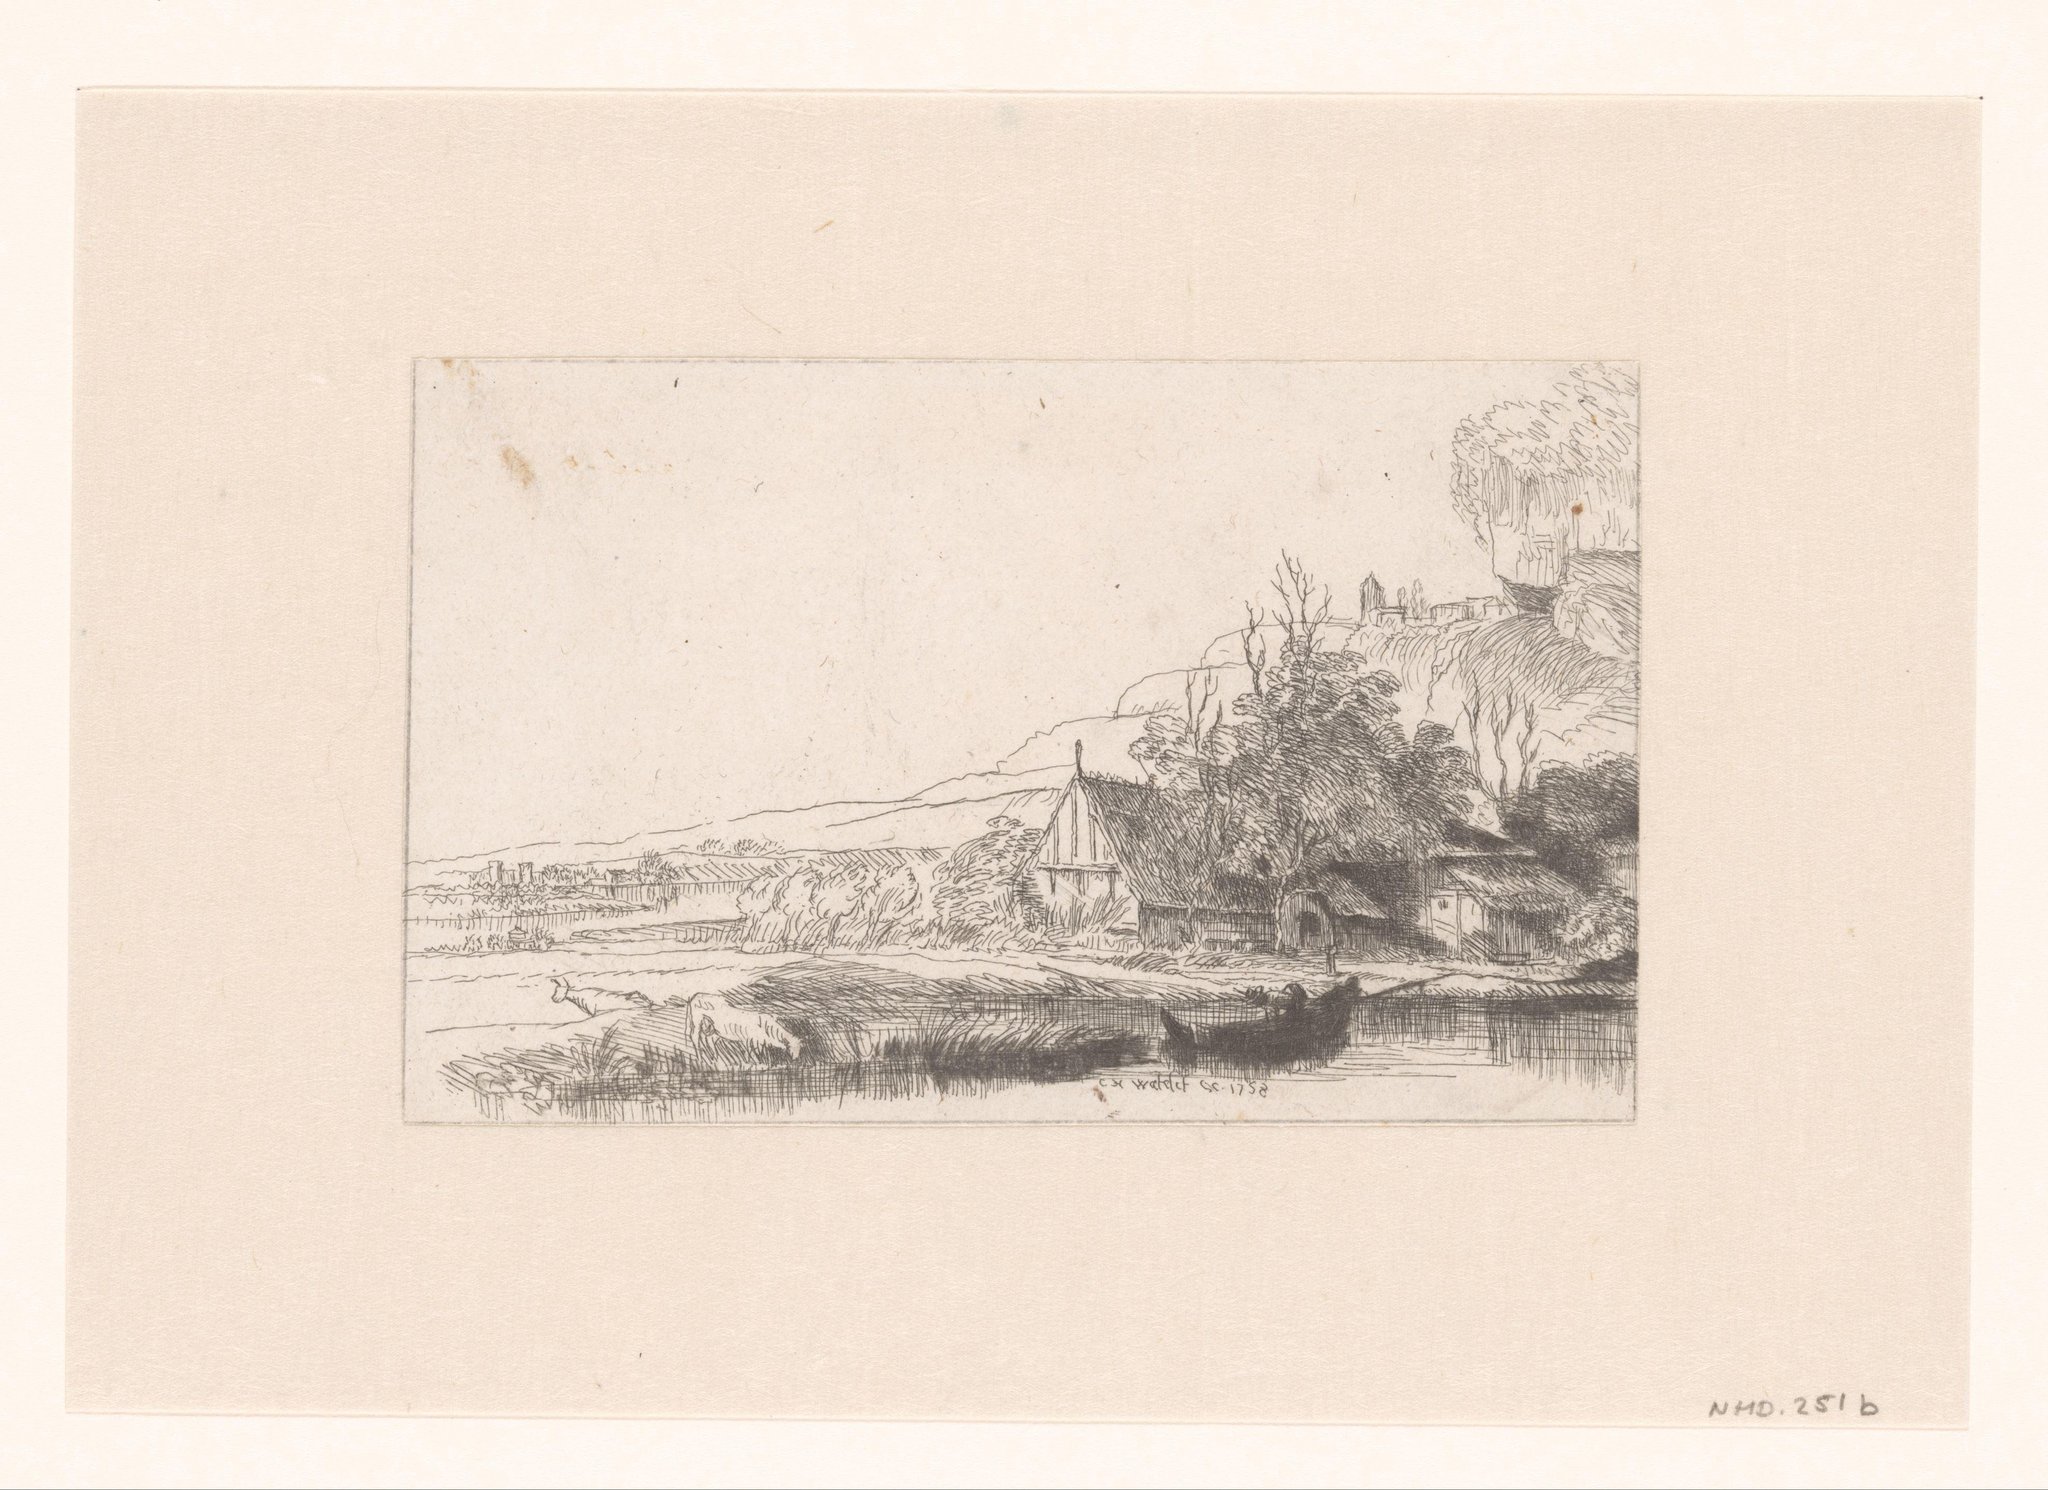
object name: print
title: Landscape with a cow drinking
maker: claude henri watelet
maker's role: print maker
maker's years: 1718-1786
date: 1758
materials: paper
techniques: etching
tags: cow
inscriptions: collector's mark: Lugt 240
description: Spiegelbeeldige kopie naar de gelijknamige prent van Rembrandt. Prent voor het eerst gebruikt in: Watelet, Claude Henri. Rymbranesques ou Essais de gravures. Parijs: s.n., 1783.